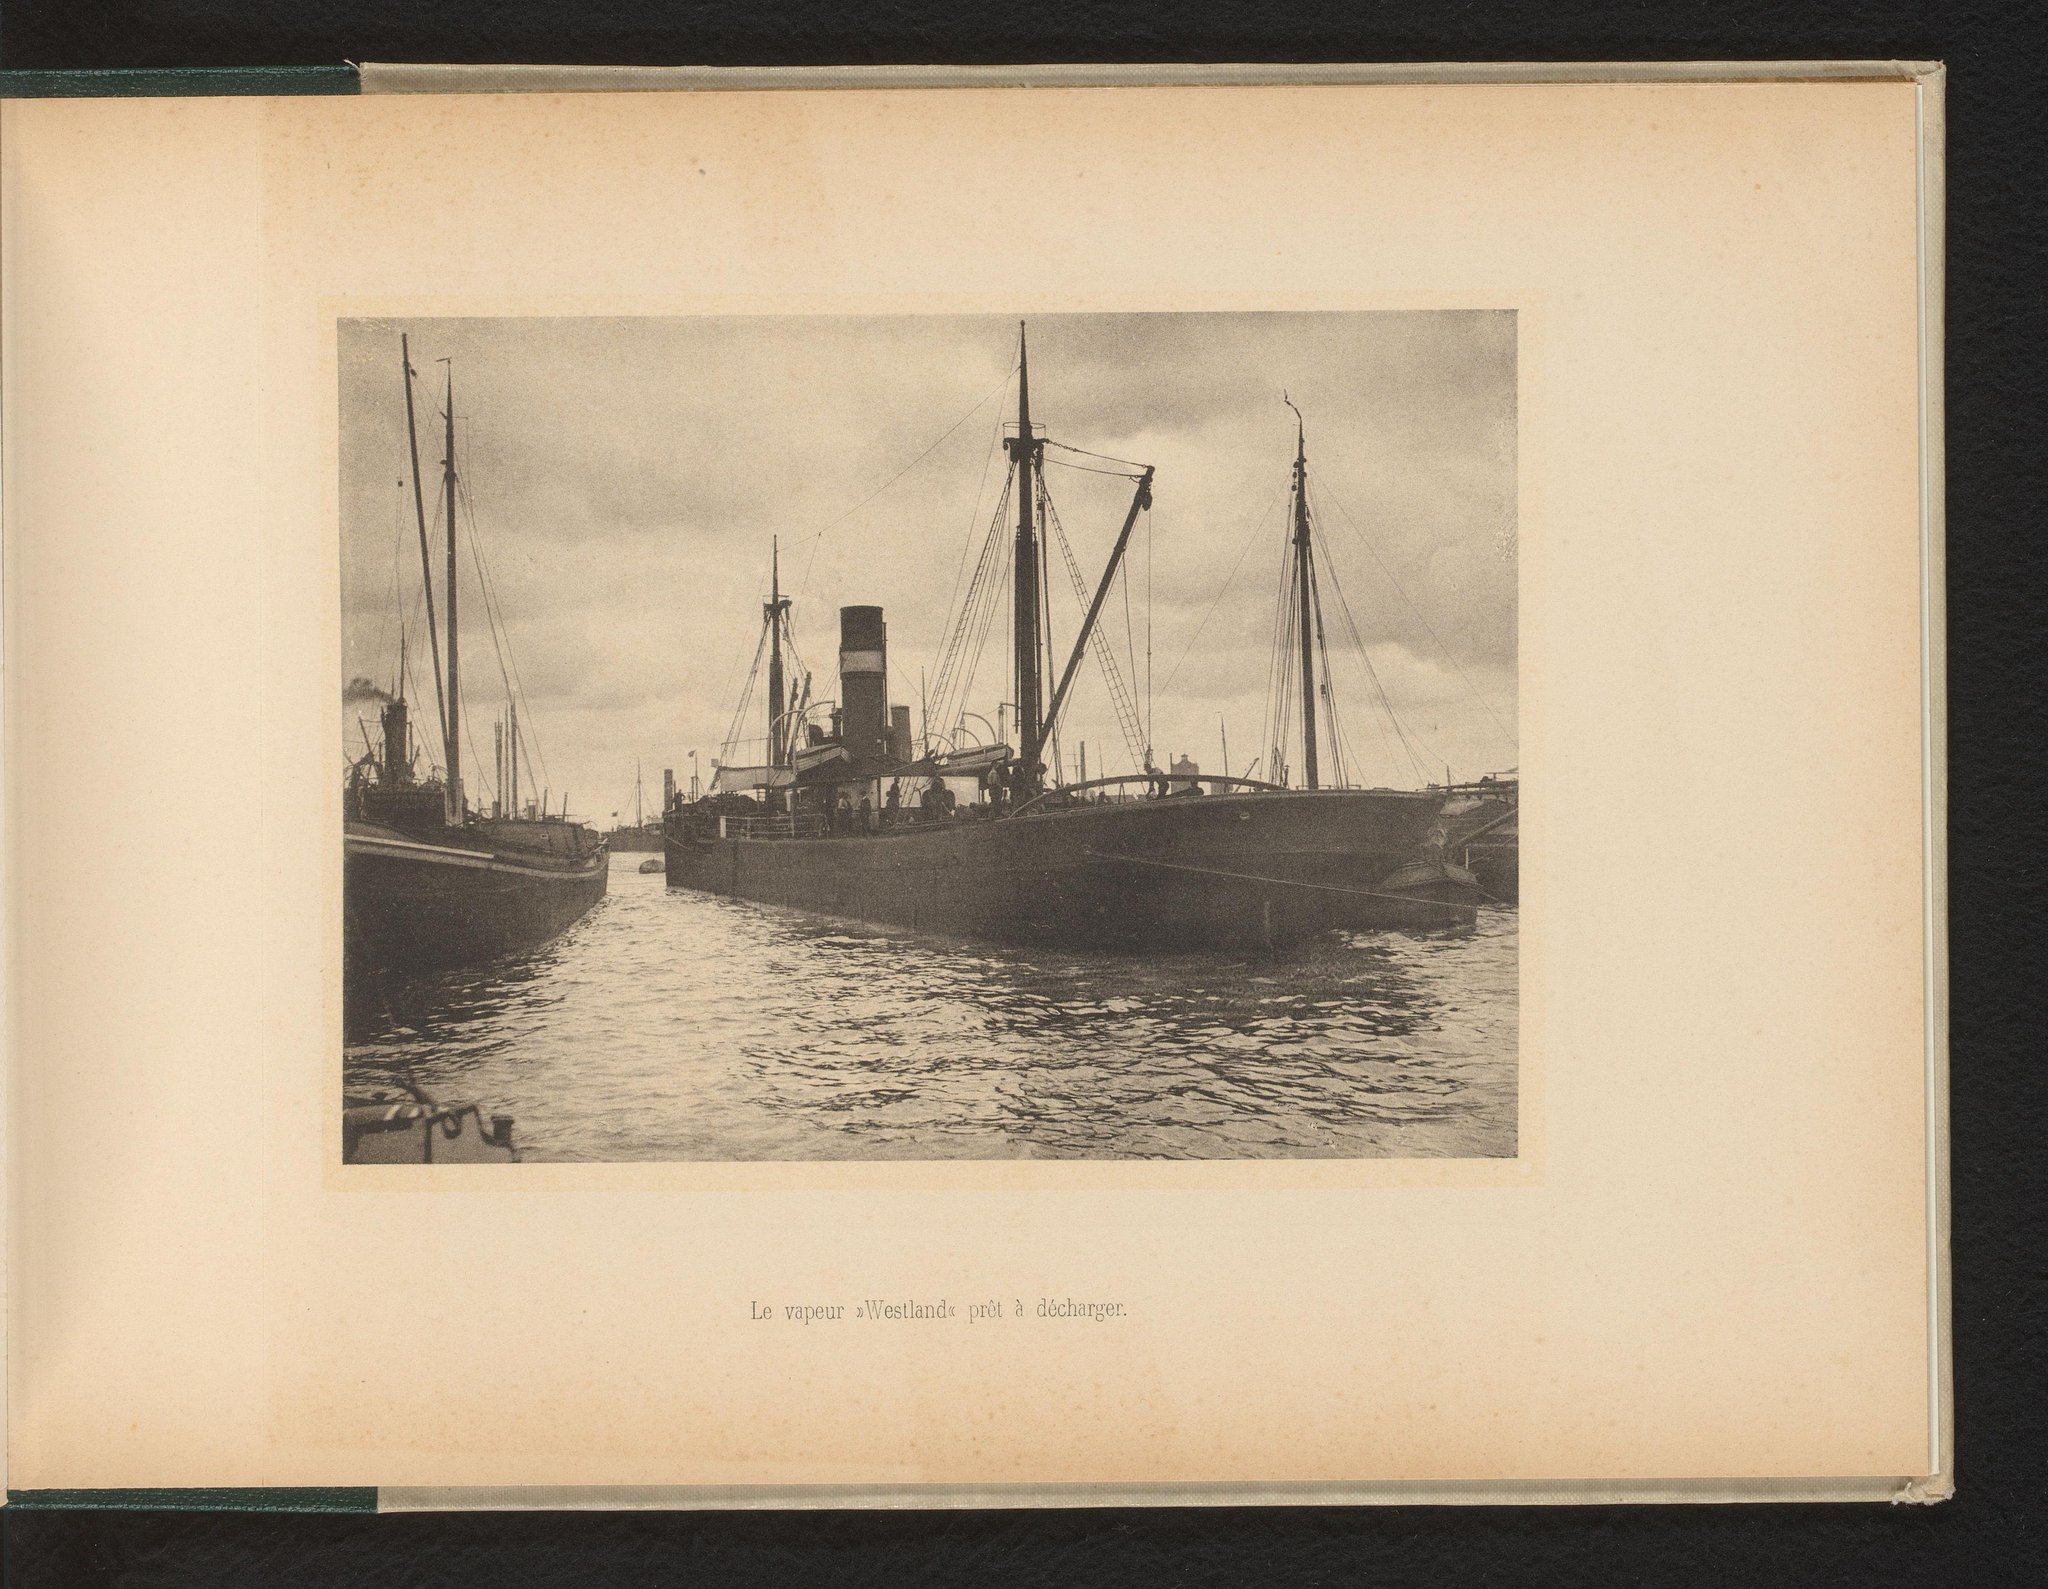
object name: photomechanical print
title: Le vapeur "Westland" prêt à décharger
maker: Anonymous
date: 1902-1907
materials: paper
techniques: photograph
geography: rotterdam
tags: harbour, rotterdam